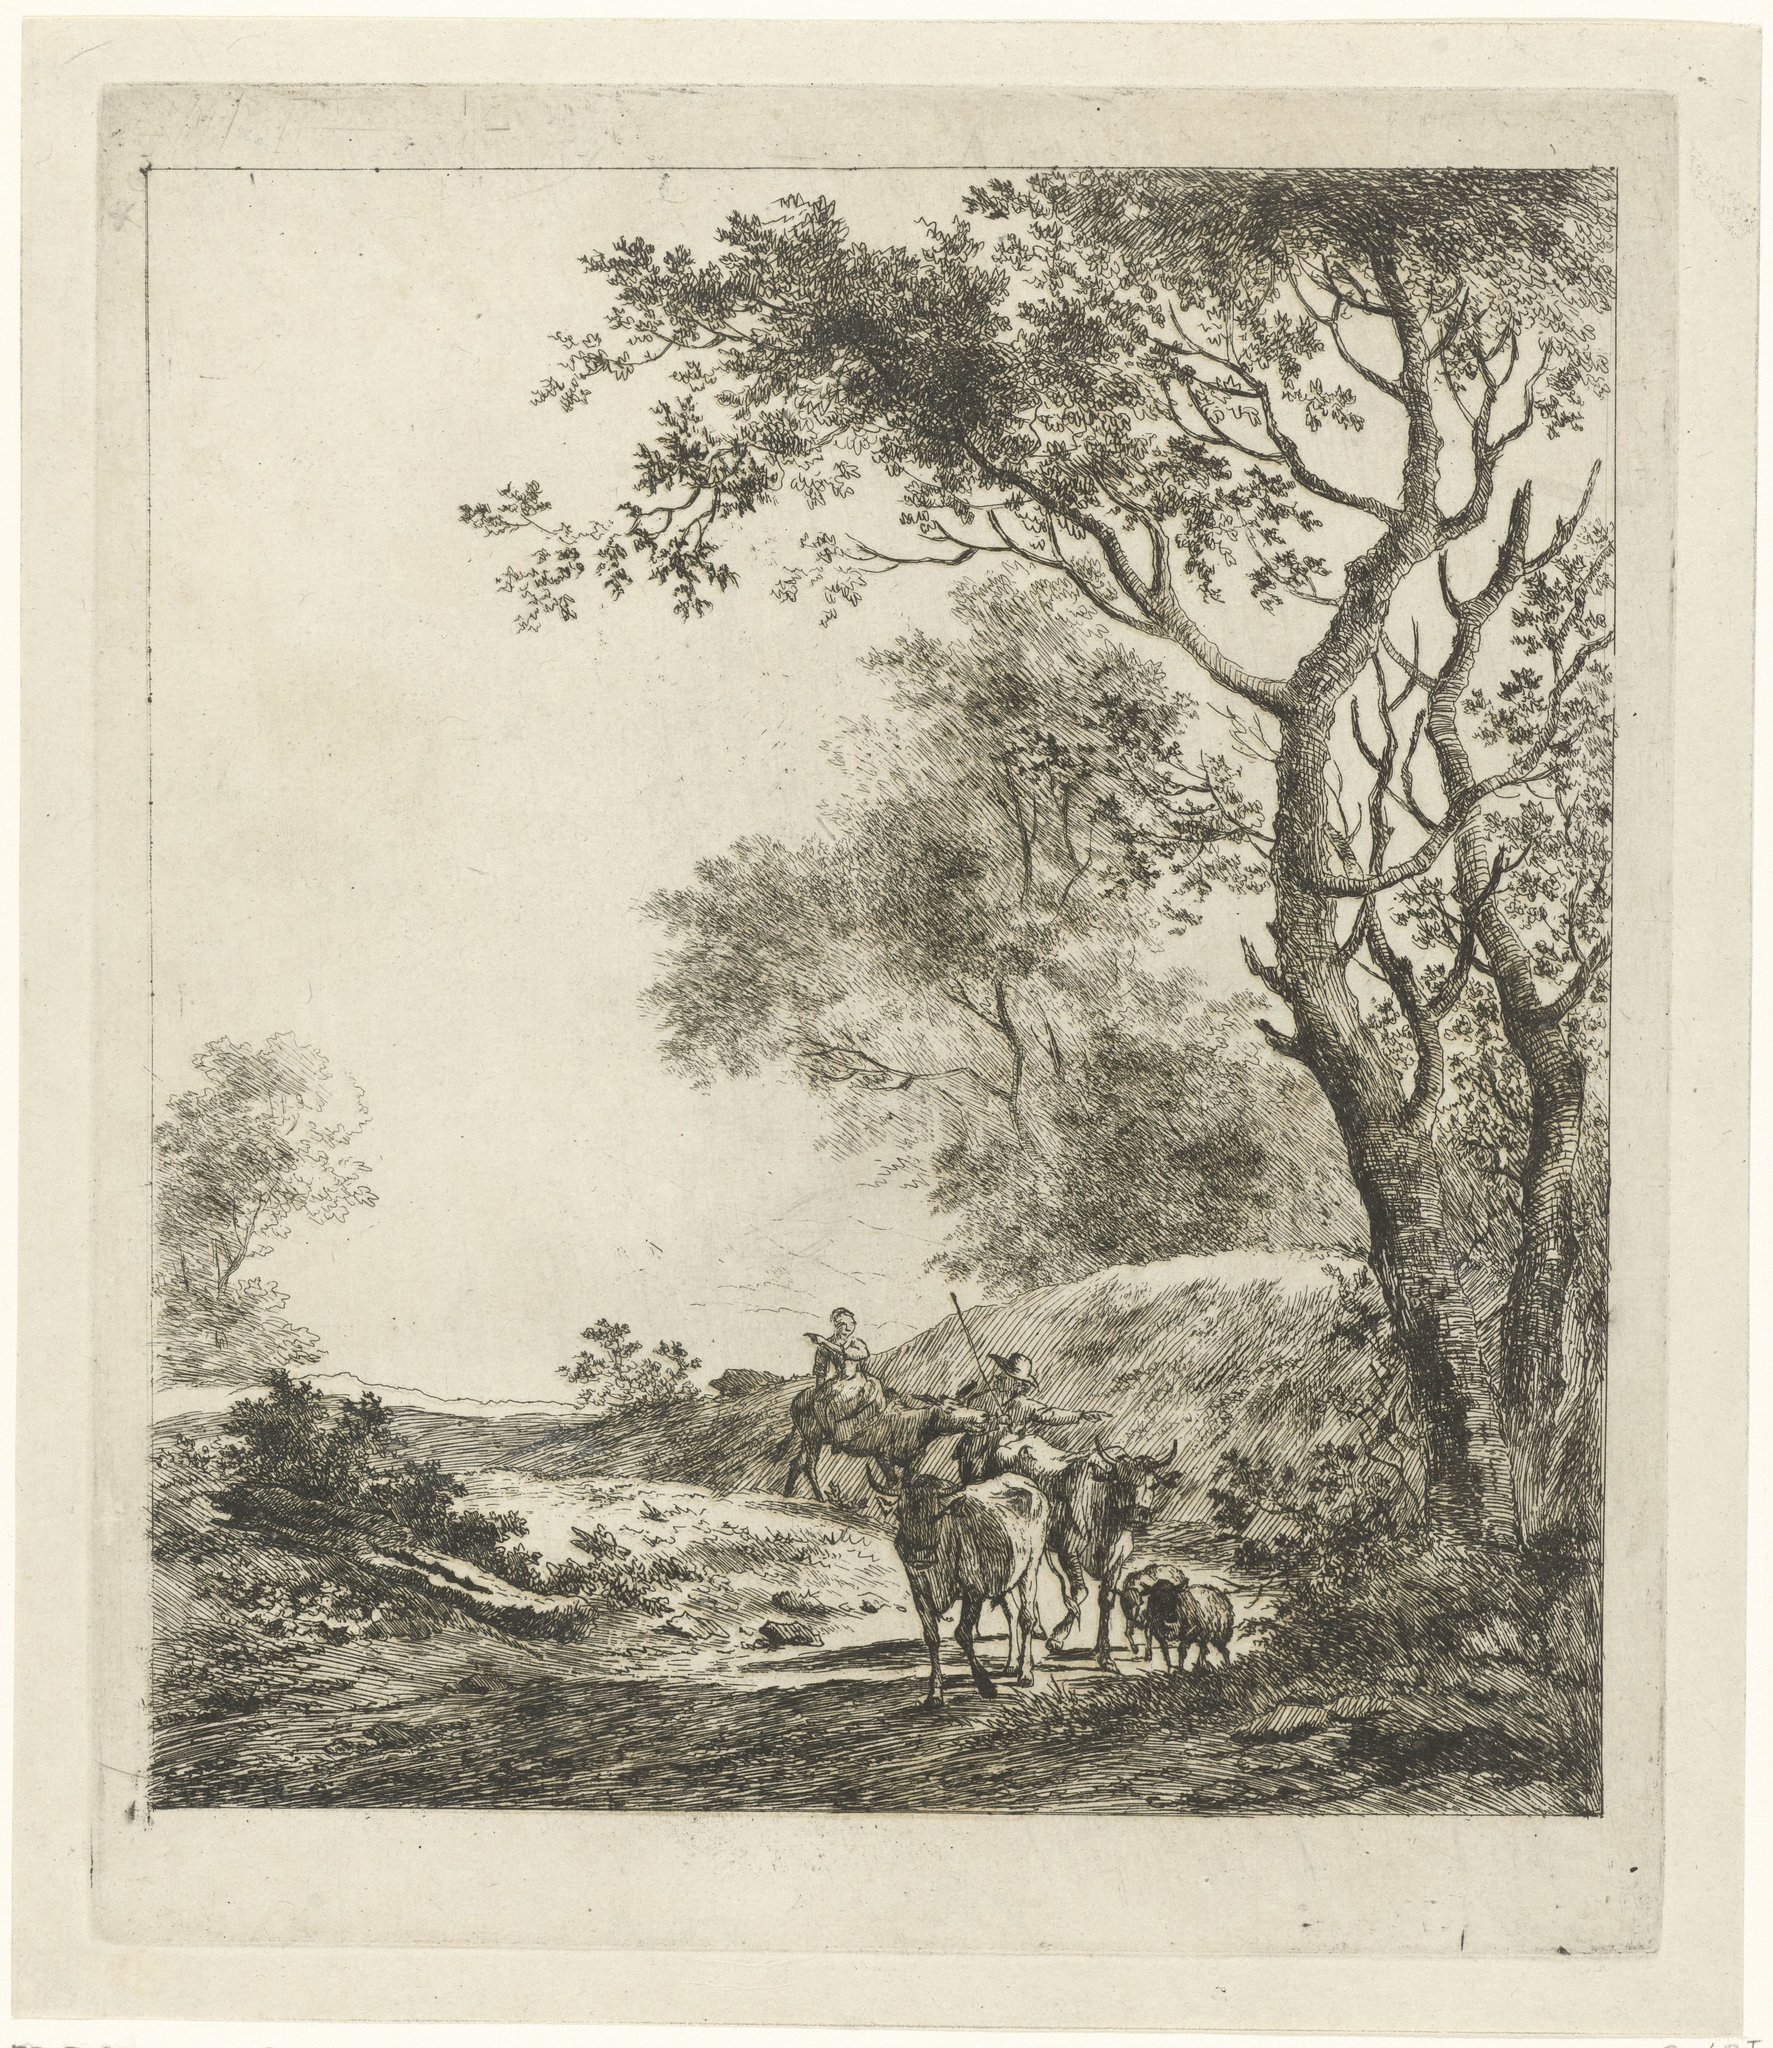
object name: print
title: Landschap met herder en vee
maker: johannes janson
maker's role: draughtsman, painter, print maker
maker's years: 1729-1784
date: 1761-1784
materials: paper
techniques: etching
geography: leiden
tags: ass, donkey, pastorals, arcadian scenes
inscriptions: collector's mark: Lugt 240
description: Bergachtig landschap met een pad waarop een herder die zijn vee voortdrijft. Achter hem een herderin, zittend op een ezel. Vóór de lucht en vóór de bergen en stadsmuur links op de achtergrond.